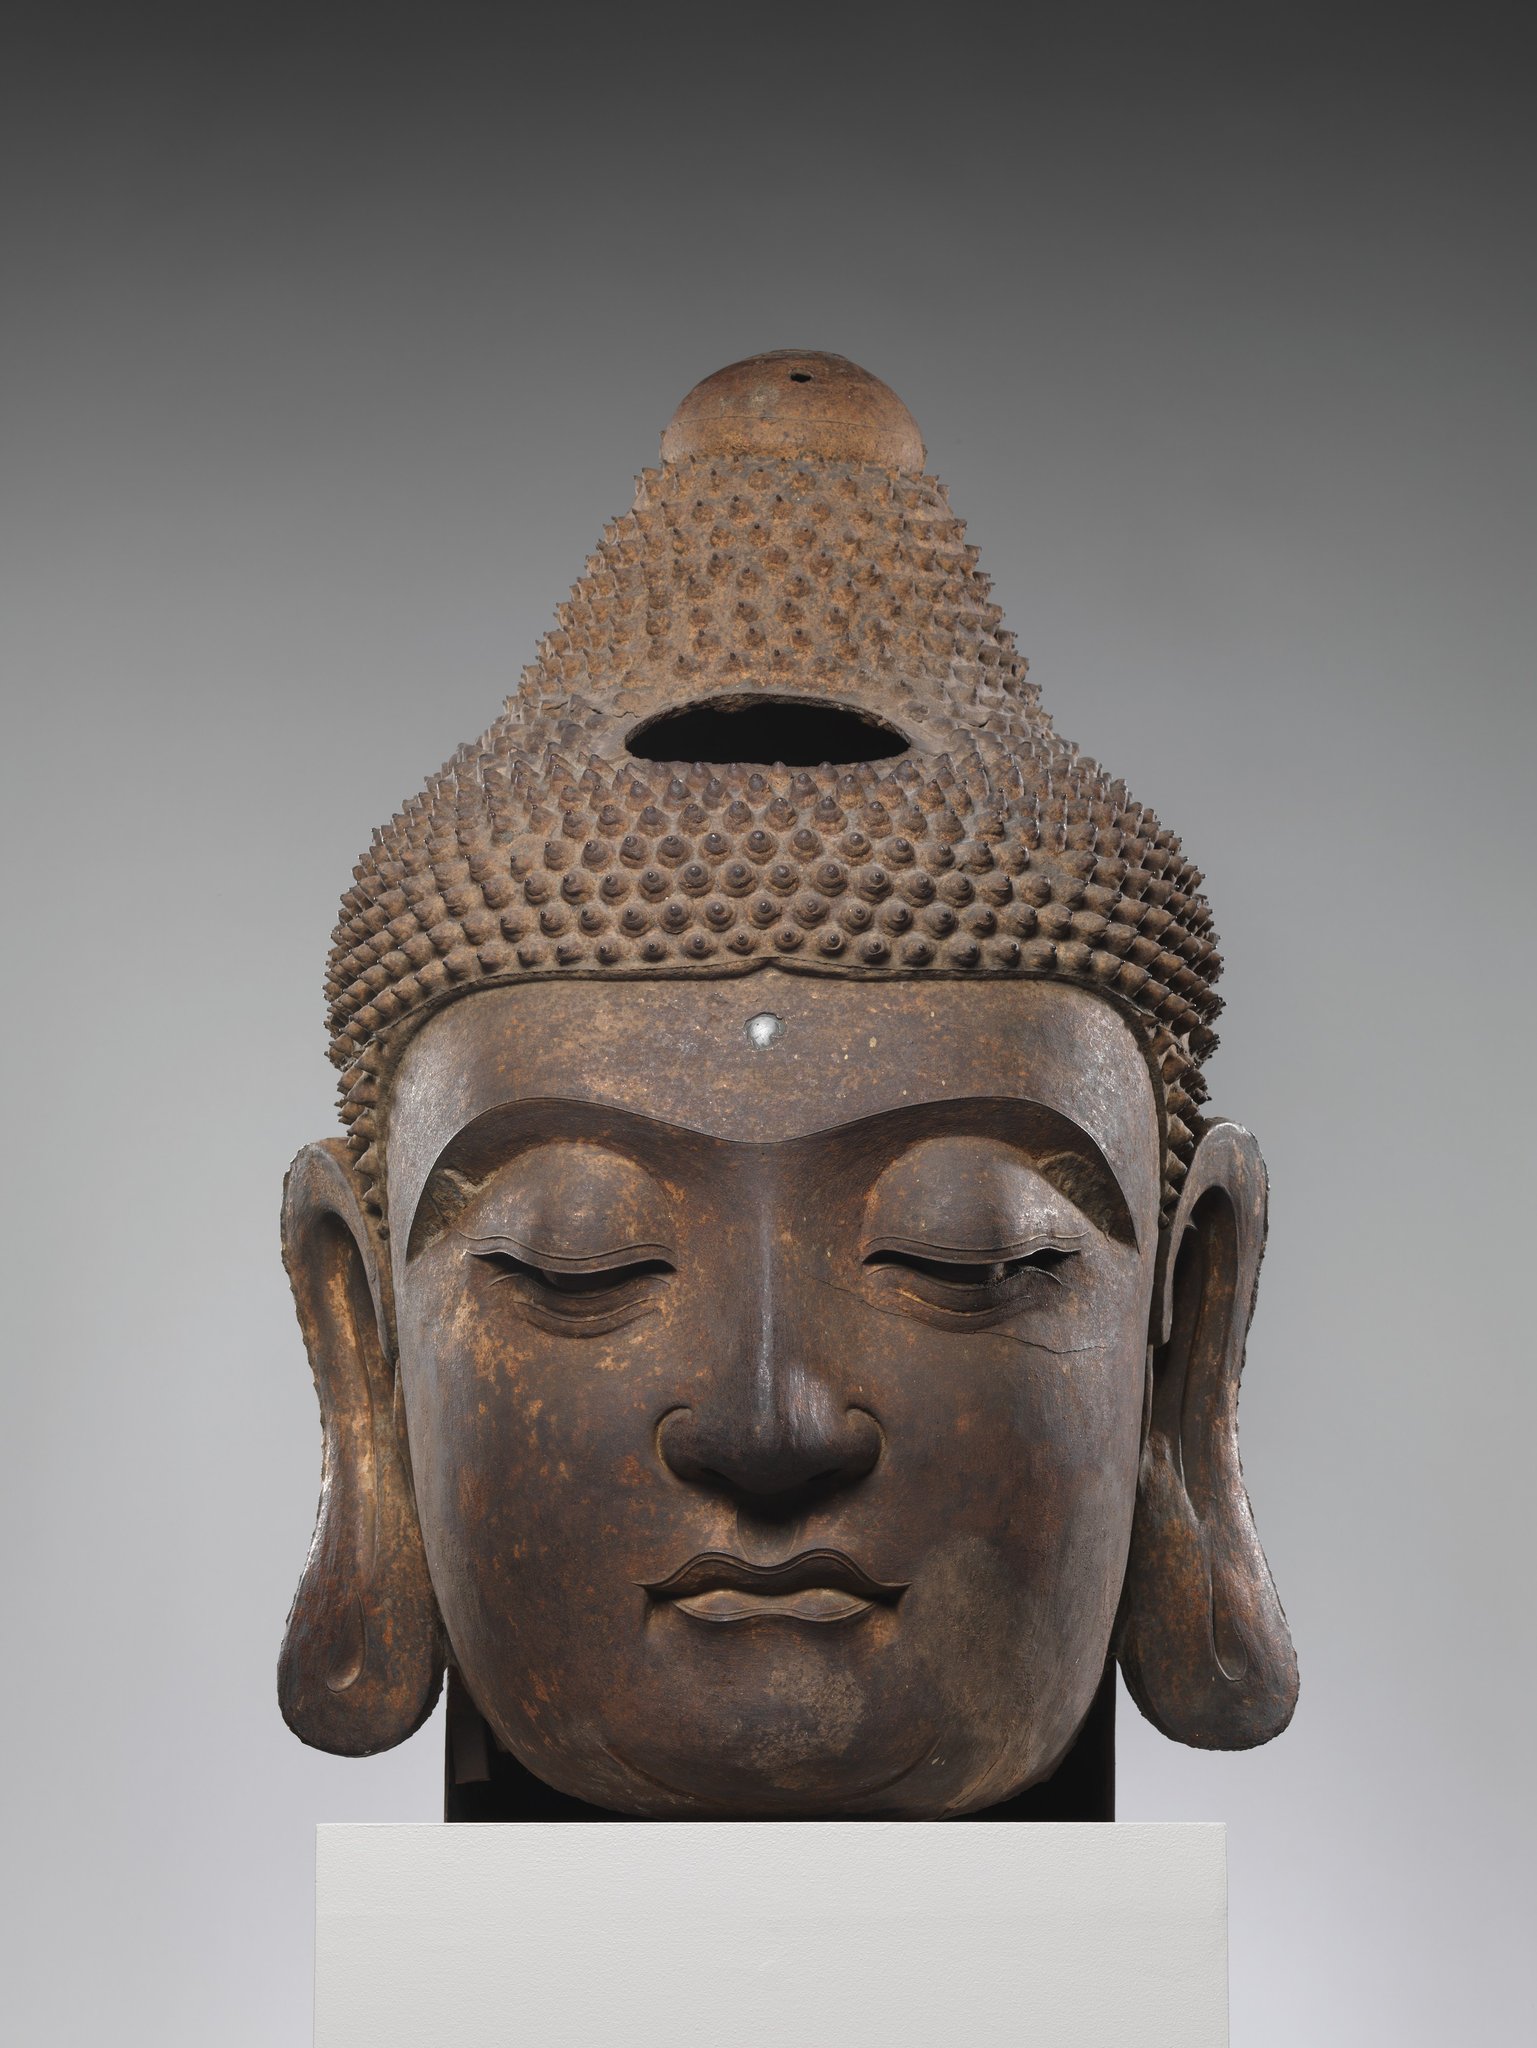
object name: head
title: Head of Buddha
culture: chinese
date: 1500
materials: iron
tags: heads,buddhism,buddha